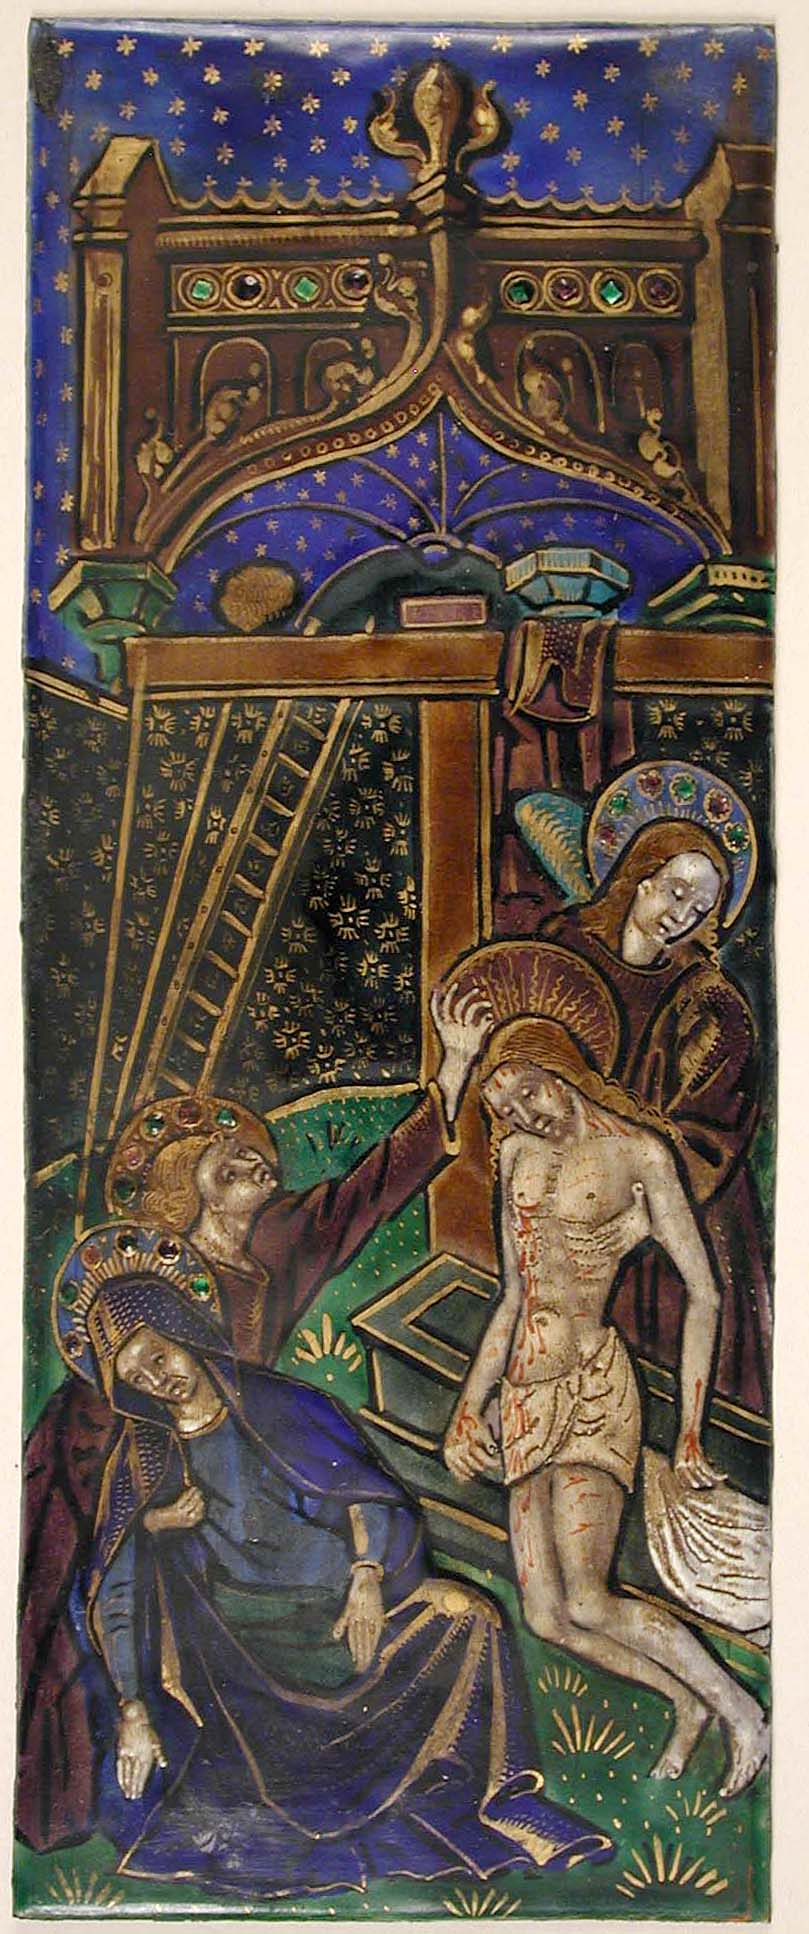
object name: triptych panel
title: Triptych Panel with the Lamentation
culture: french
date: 1501-1533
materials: copper, enamel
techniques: painting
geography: france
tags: men,women,christ